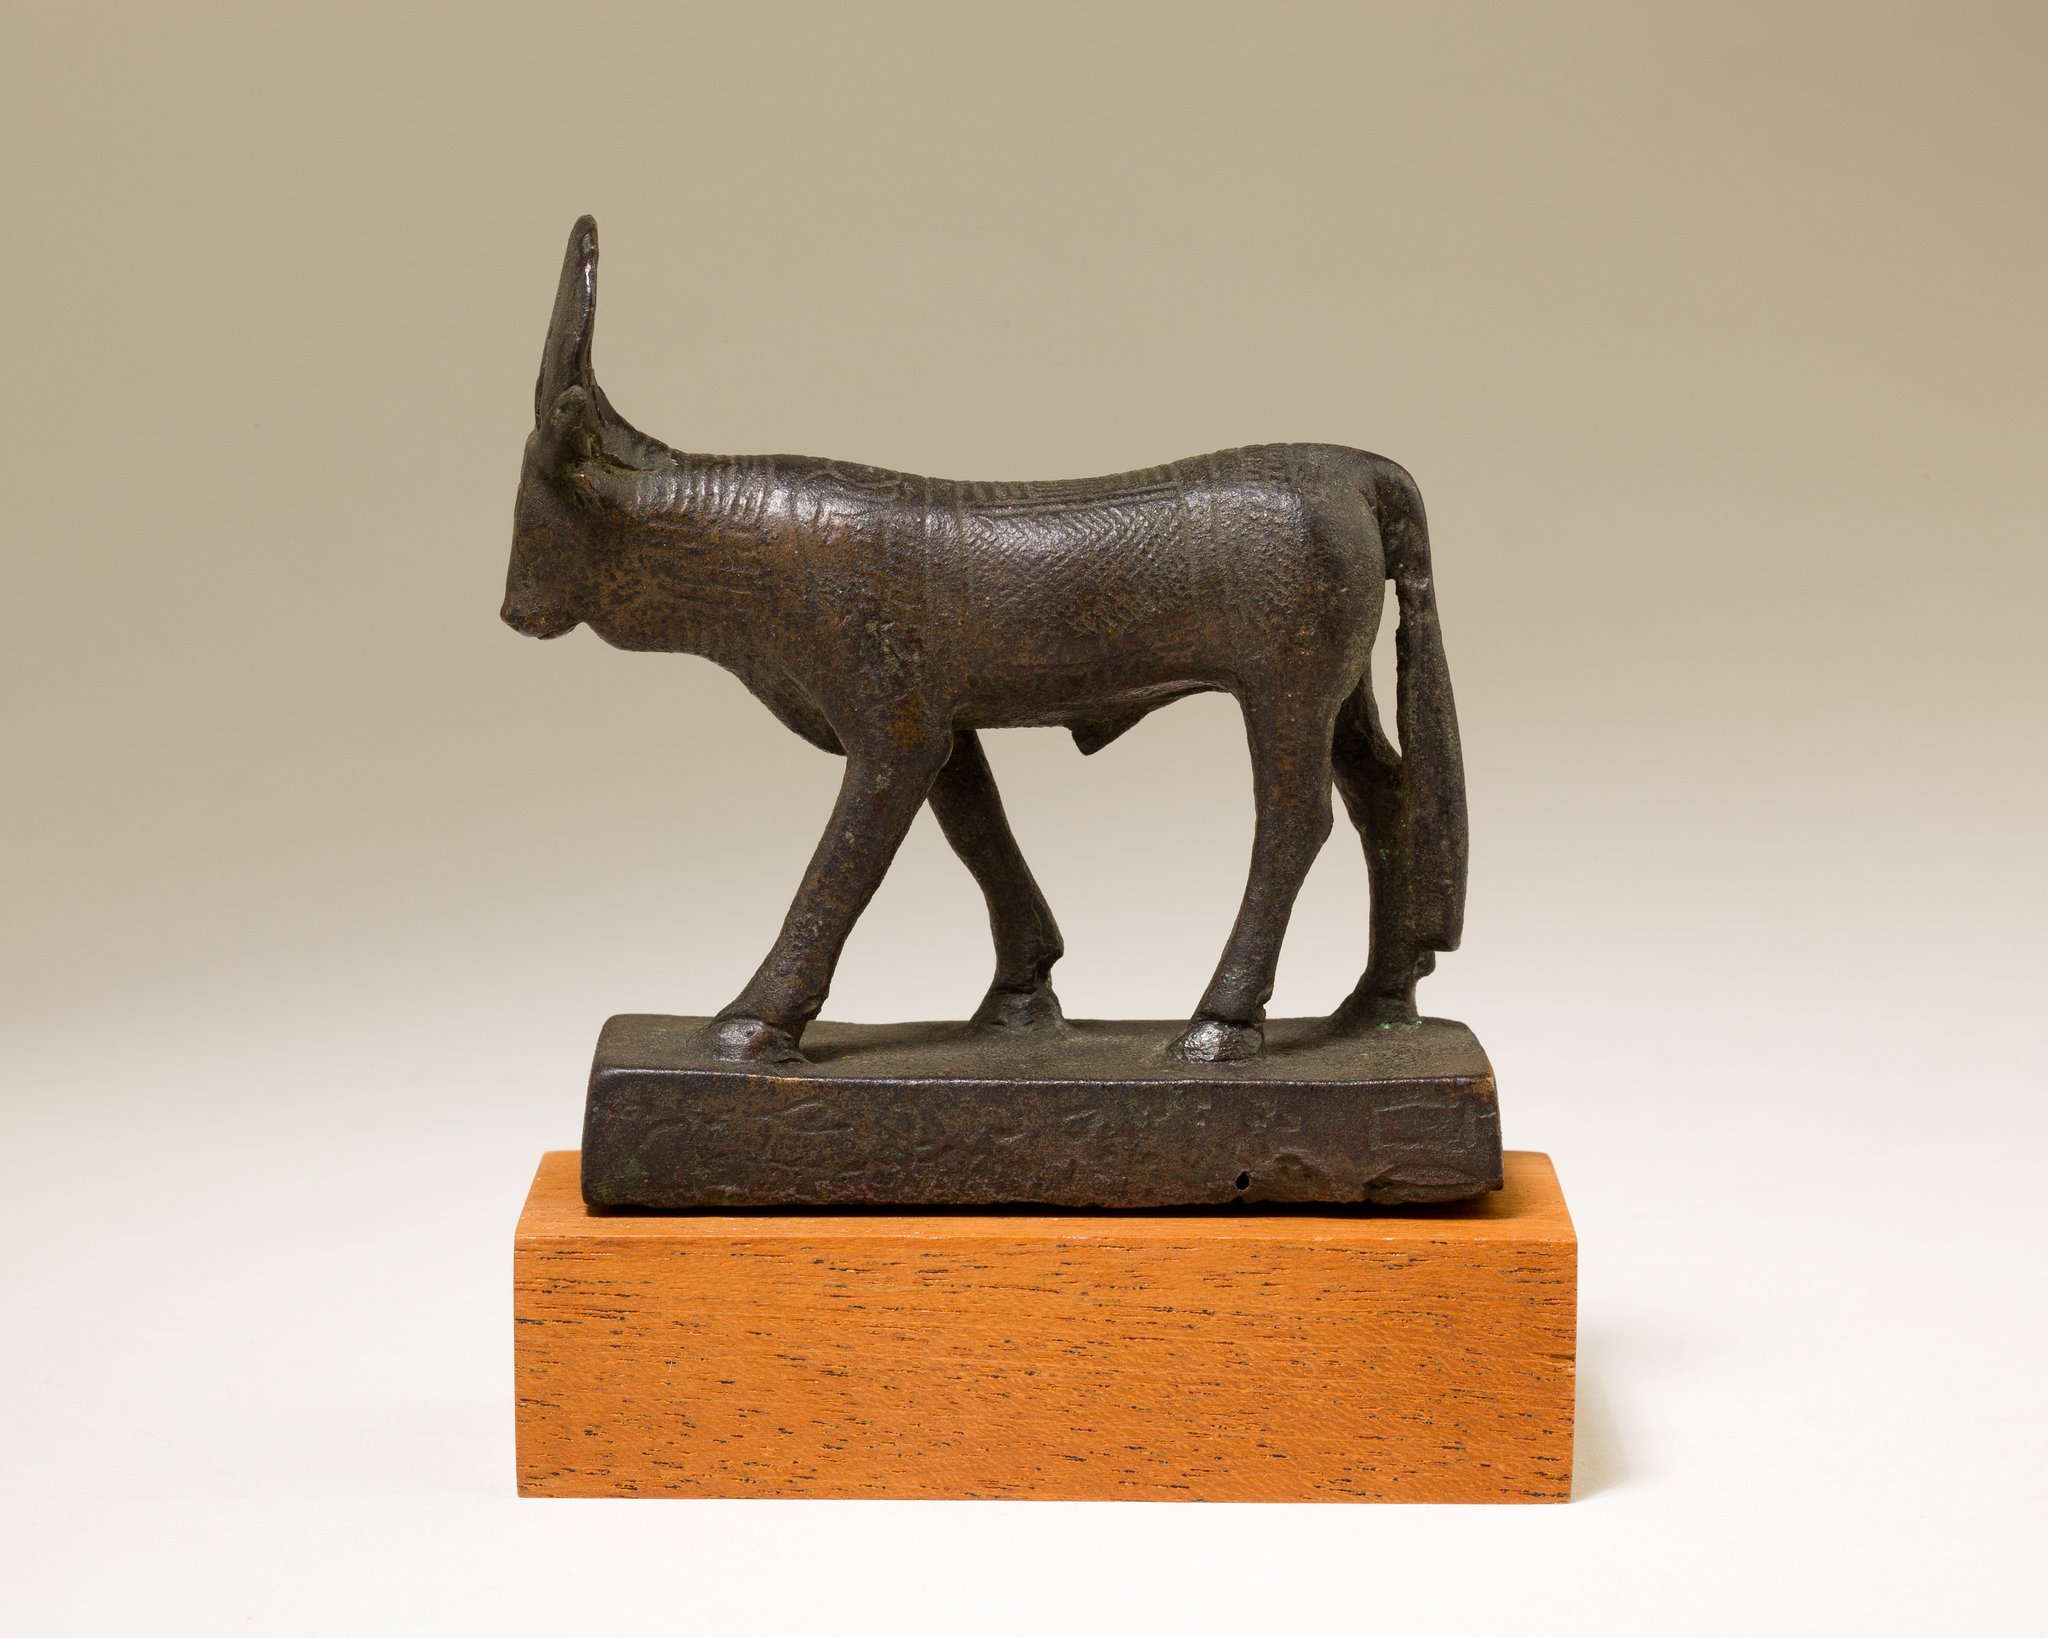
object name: figurine, apis, padishernefer, khonsuirdis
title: Apis figure inscribed for Padishernefer son of Khonsuirdis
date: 664-200 BCE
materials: metal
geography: egypt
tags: bulls